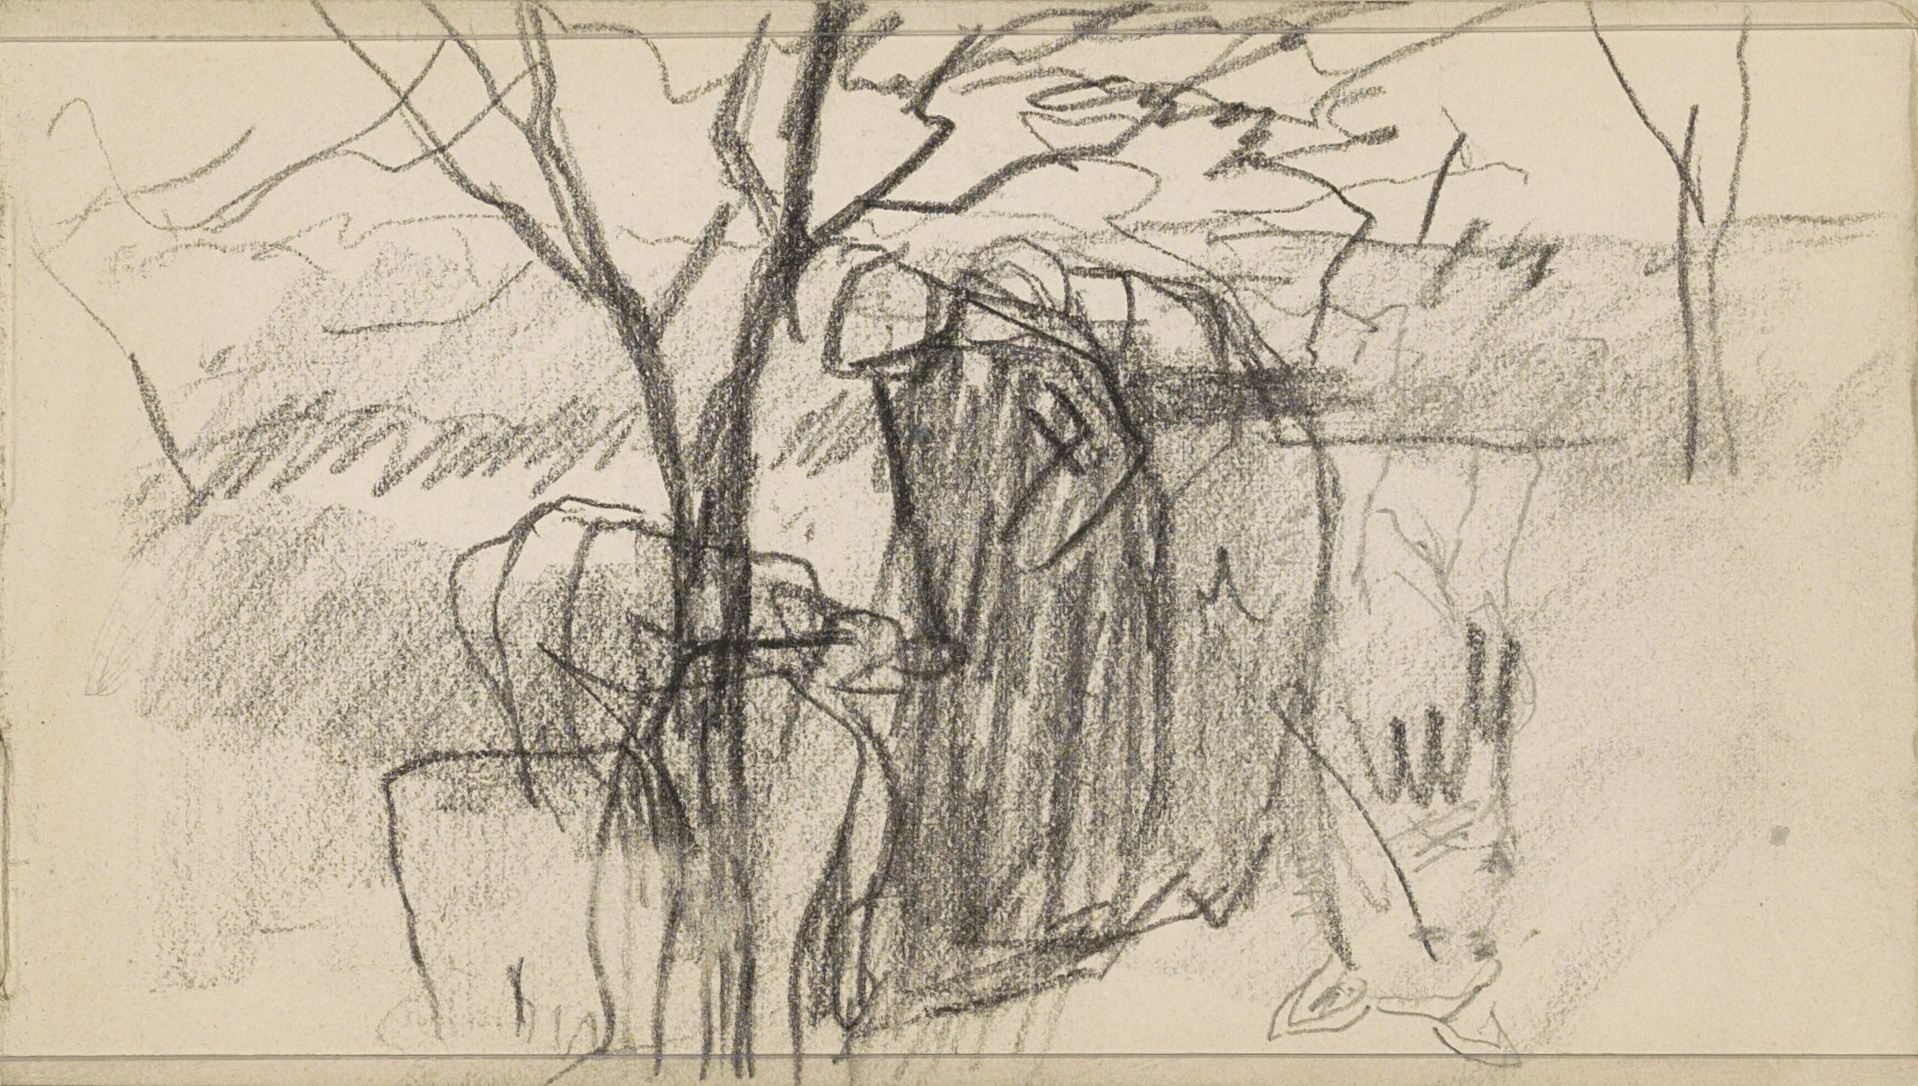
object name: sketchbook leaf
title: Boerin voorover buigend naar enkele schapen bij een boom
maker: anton mauve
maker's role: draughtsman, painter, print maker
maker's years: 1838-1888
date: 1876-1879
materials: chalk, paper, pencil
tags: farmers - aa - female farmer, farmer's wife, sheep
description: Blad 27 recto uit een schetsboek met 33 bladen.